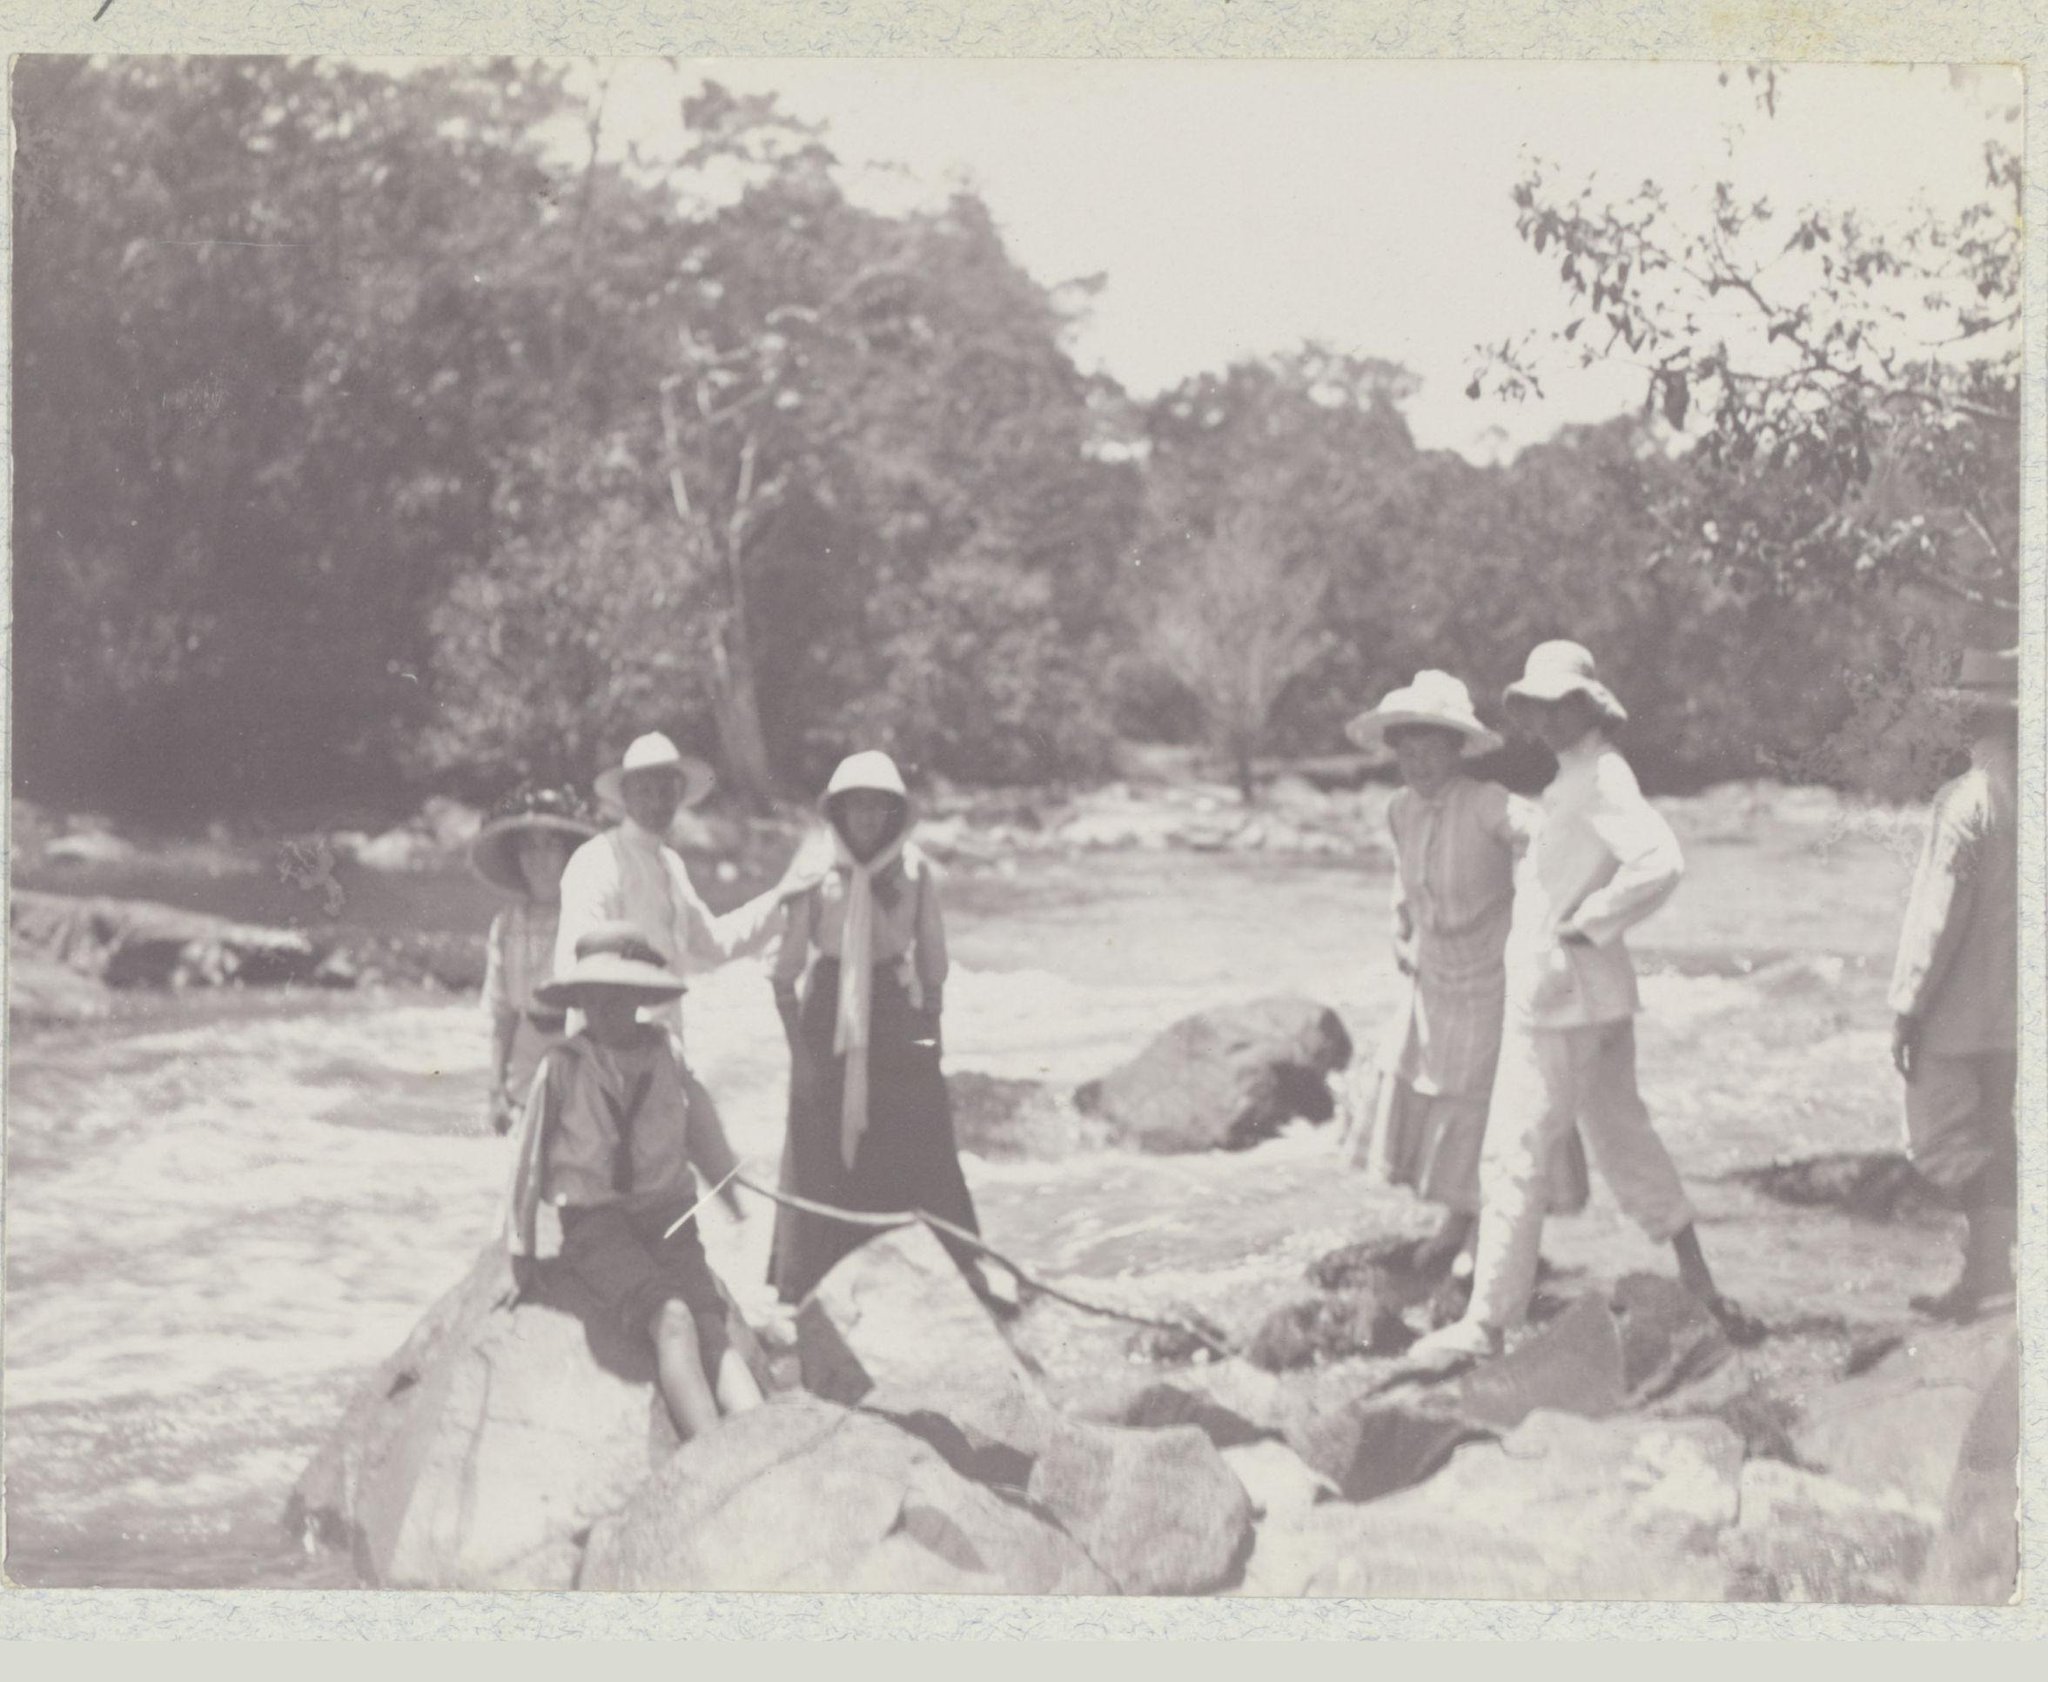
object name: photograph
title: Sarakreek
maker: Anonymous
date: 1909-1911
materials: photographic support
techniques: photography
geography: suriname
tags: landscapes in tropical and sub-tropical regions, suriname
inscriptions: inscription: ‘1911. Sarakreek, Suriname’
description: Gezelschap bij de rotsen aan de waterkant van de Sarakreek, september 1911. Onderdeel van het fotoalbum van de familie Boom-Gonggrijp in Suriname en Curaçao.